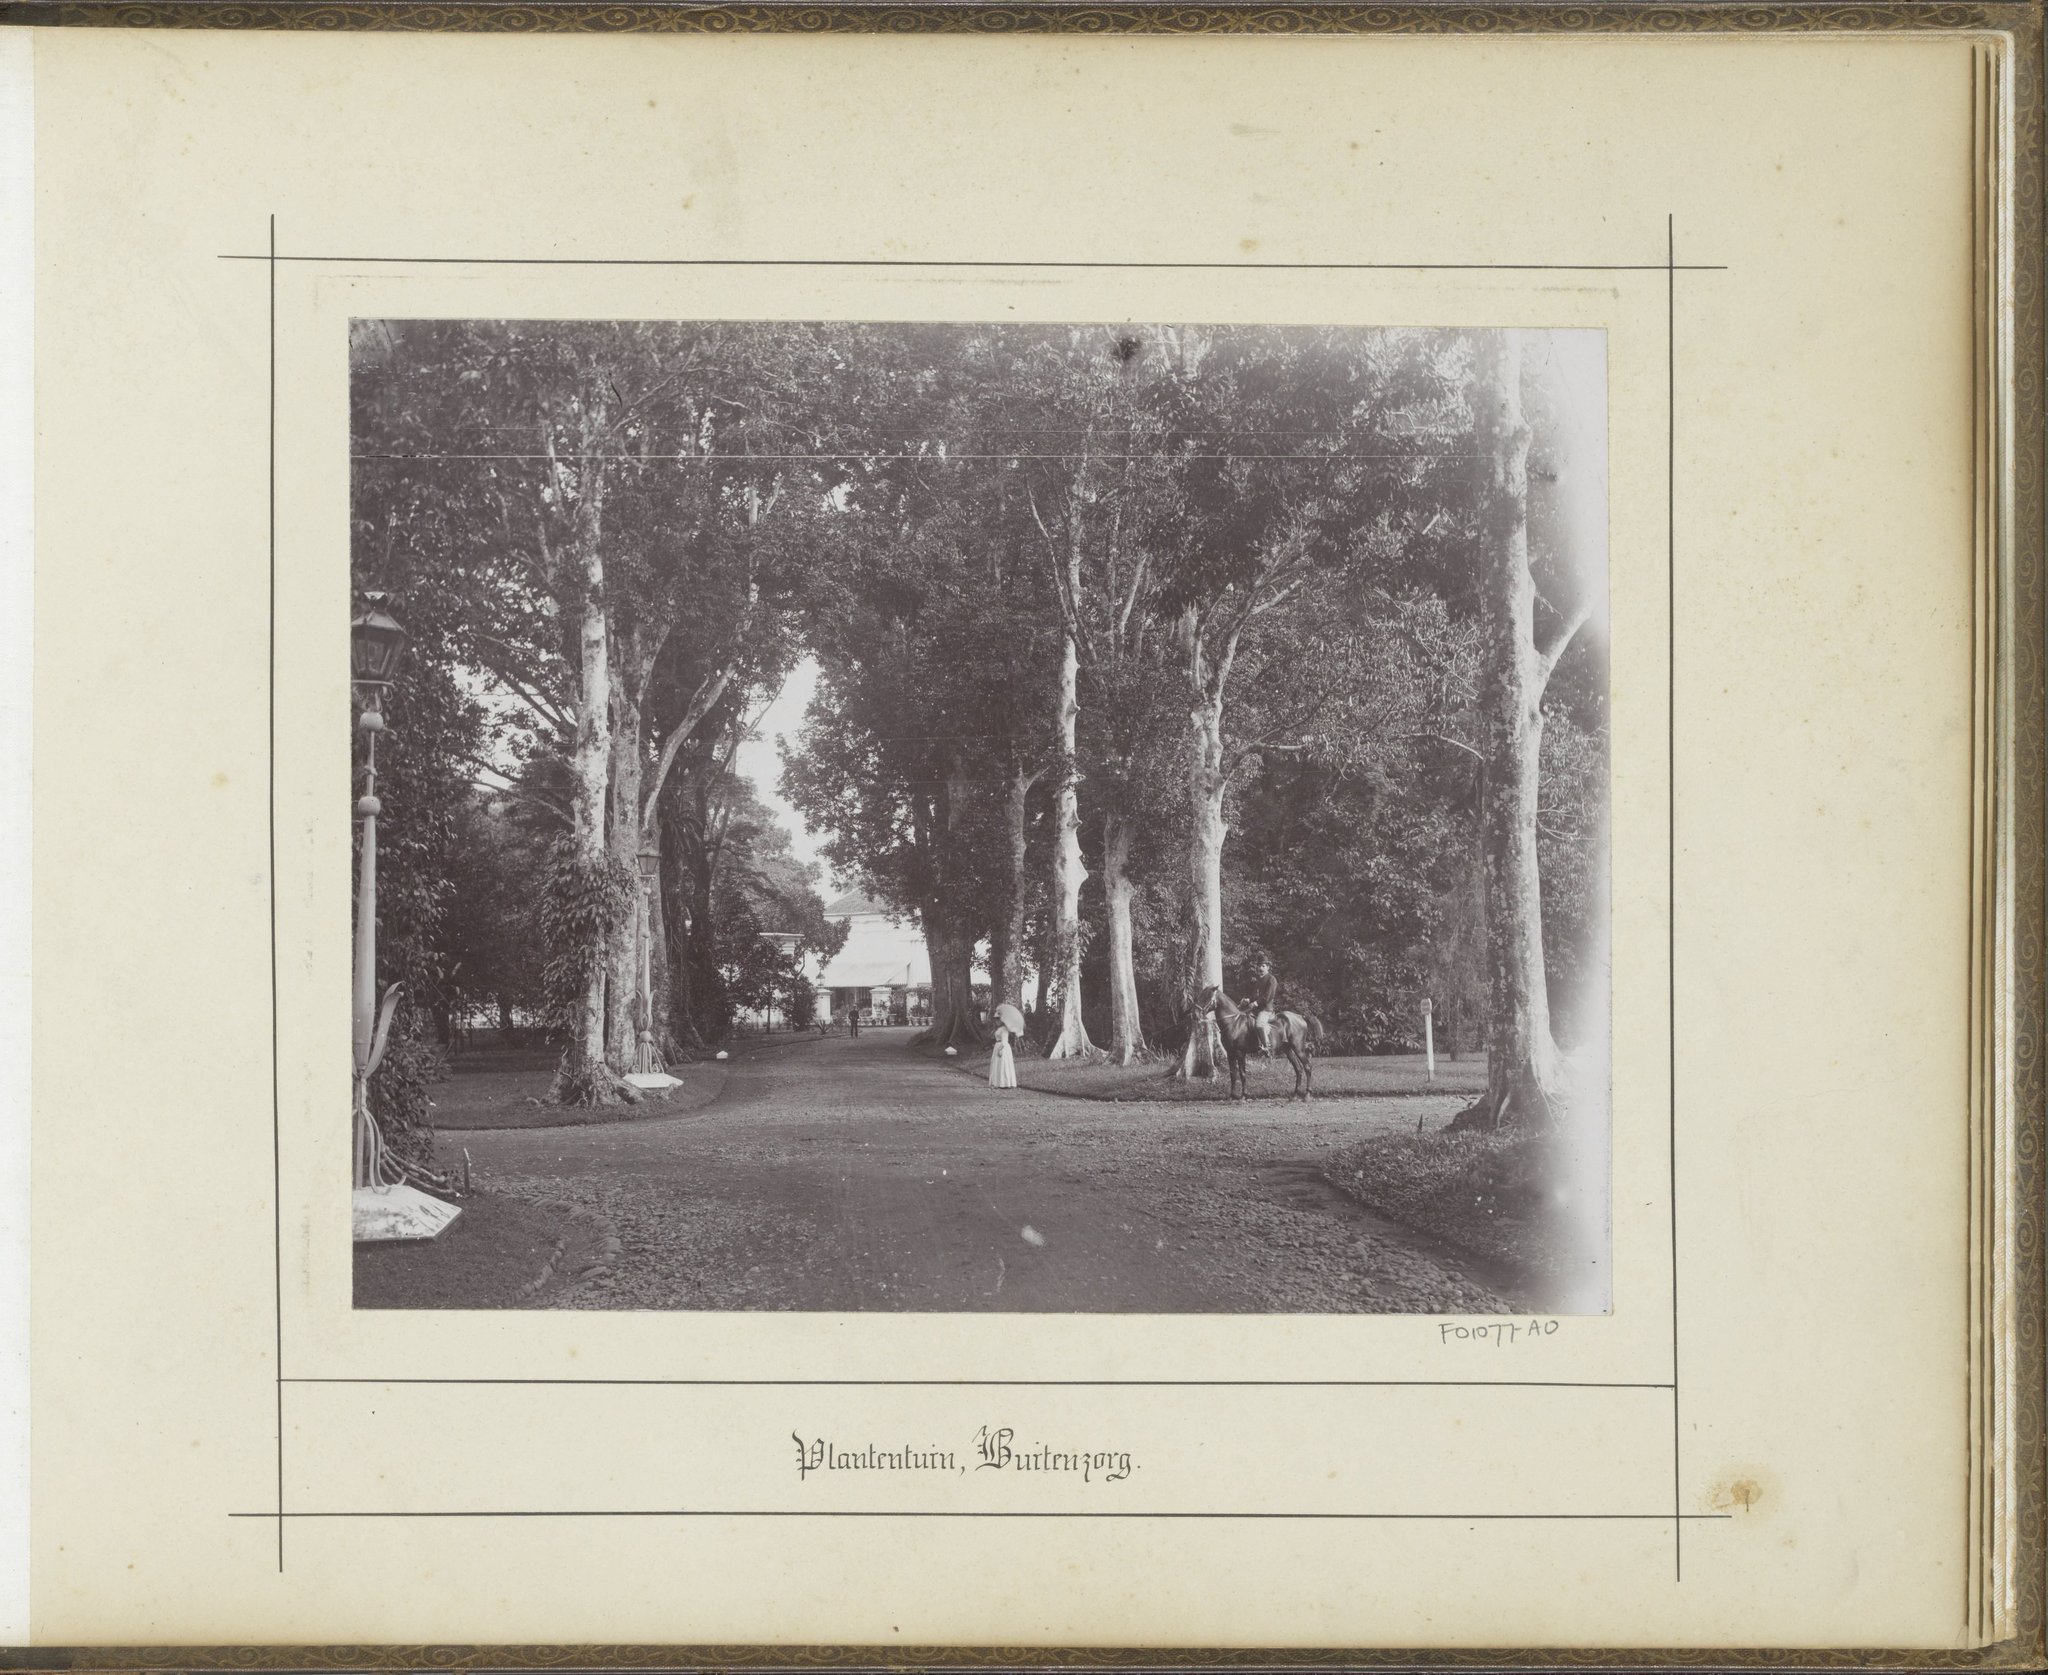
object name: album leaf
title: Plantentuin, Buitenzorg.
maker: Anonymous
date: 1890-1910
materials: cardboard, photographic support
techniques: collodion silver print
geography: s lands plantentuin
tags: riding a horse, ass, or mule; rider, horseman, botanic garden, 'hortus botanicus'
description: Onderdeel van Album met foto's van Batavia en van de zusters Ursulinen.